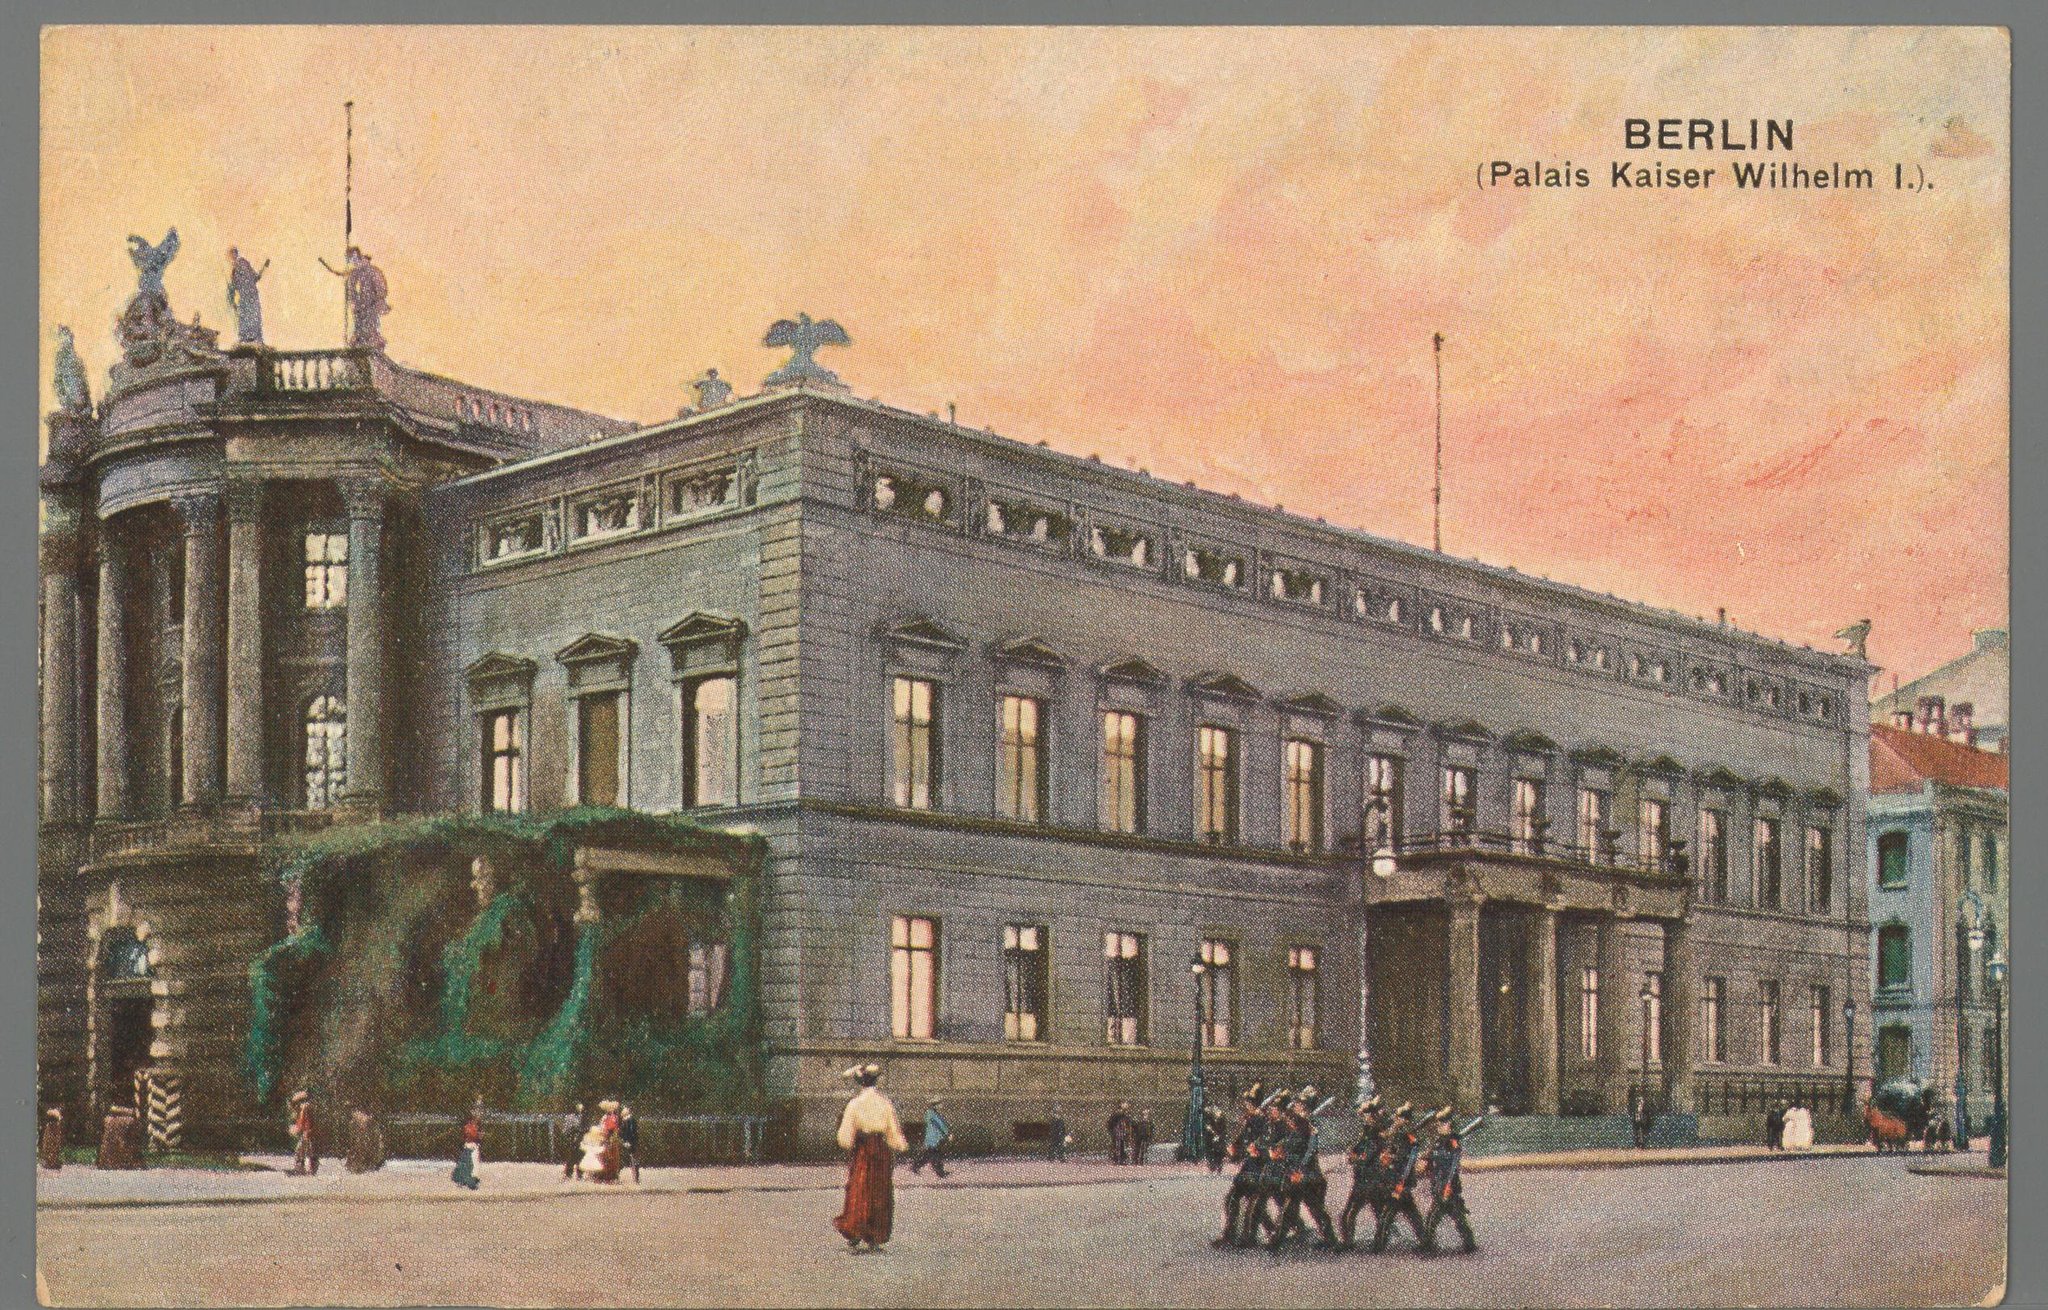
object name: ansichtkaart, prentbriefkaart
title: Berlin. (Palais Kaiser Wilhelm I.)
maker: Anonymous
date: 1905-1930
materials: cardboard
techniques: color autotype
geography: munich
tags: palace